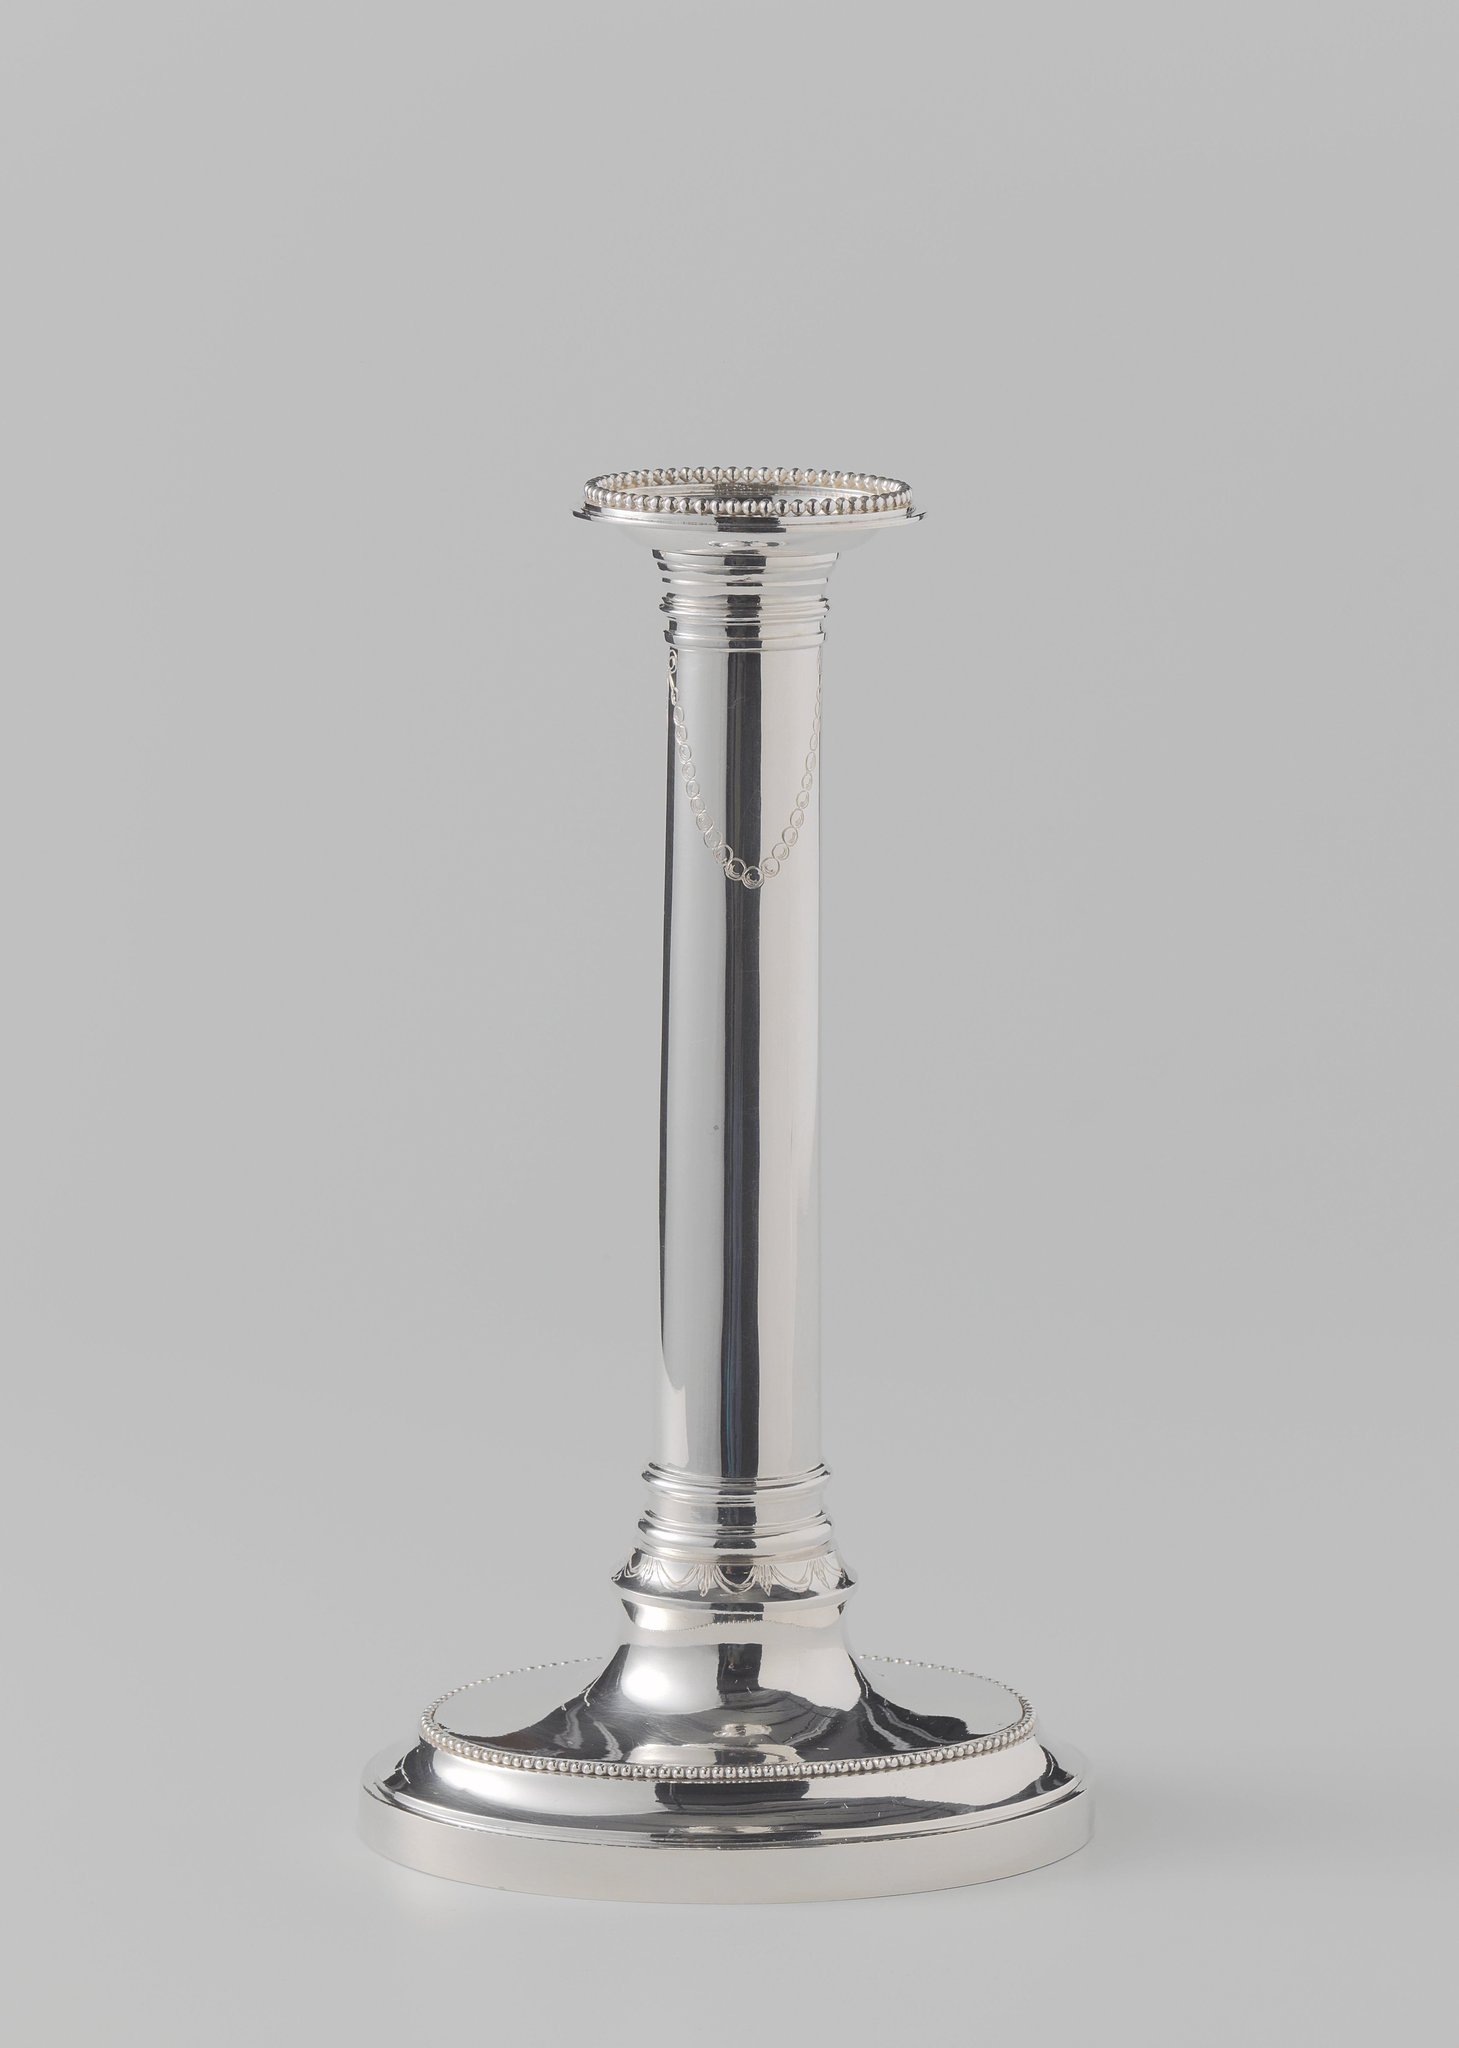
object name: candlestick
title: Kandelaar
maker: hendrik boshart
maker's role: silversmith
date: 1789-1790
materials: silver, velvet, wood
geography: middelburg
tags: voorburg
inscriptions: mark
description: Ovale kandelaar van zilver. De voet en de vetvanger versierd met een parelrand.